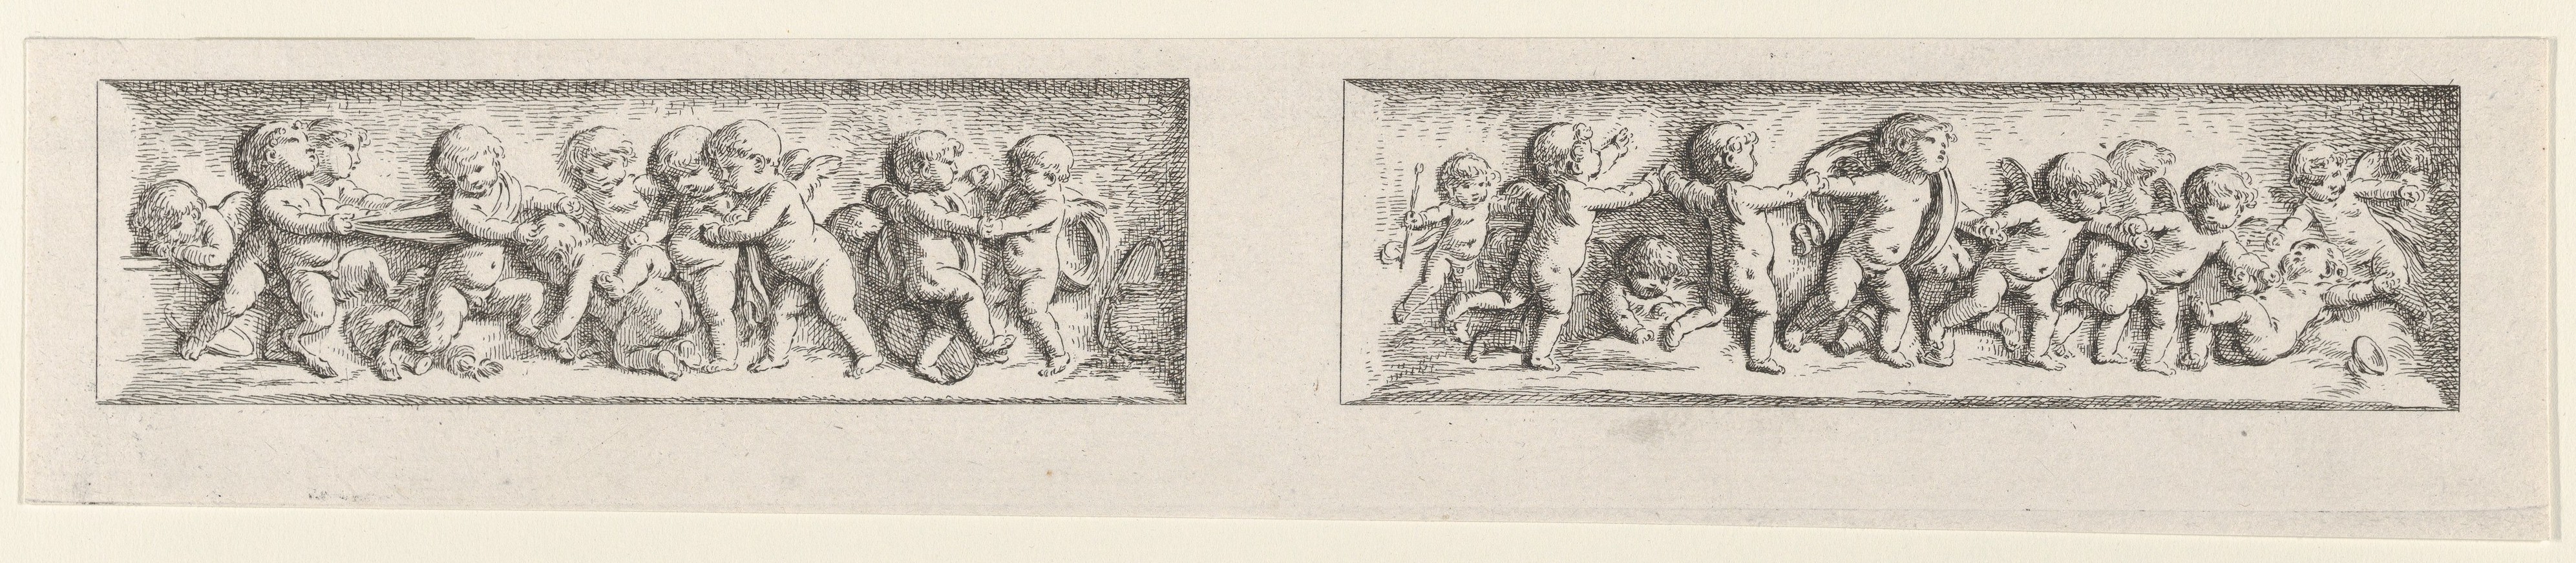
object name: print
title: Two Friezes with Playing Putti, Premier Livre, Sixieme Cahier, plate 34 from "L'Oeuvre de J. B. Huet"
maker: jean-baptiste huet i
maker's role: artist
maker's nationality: french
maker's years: 1745-1811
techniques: etching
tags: putti